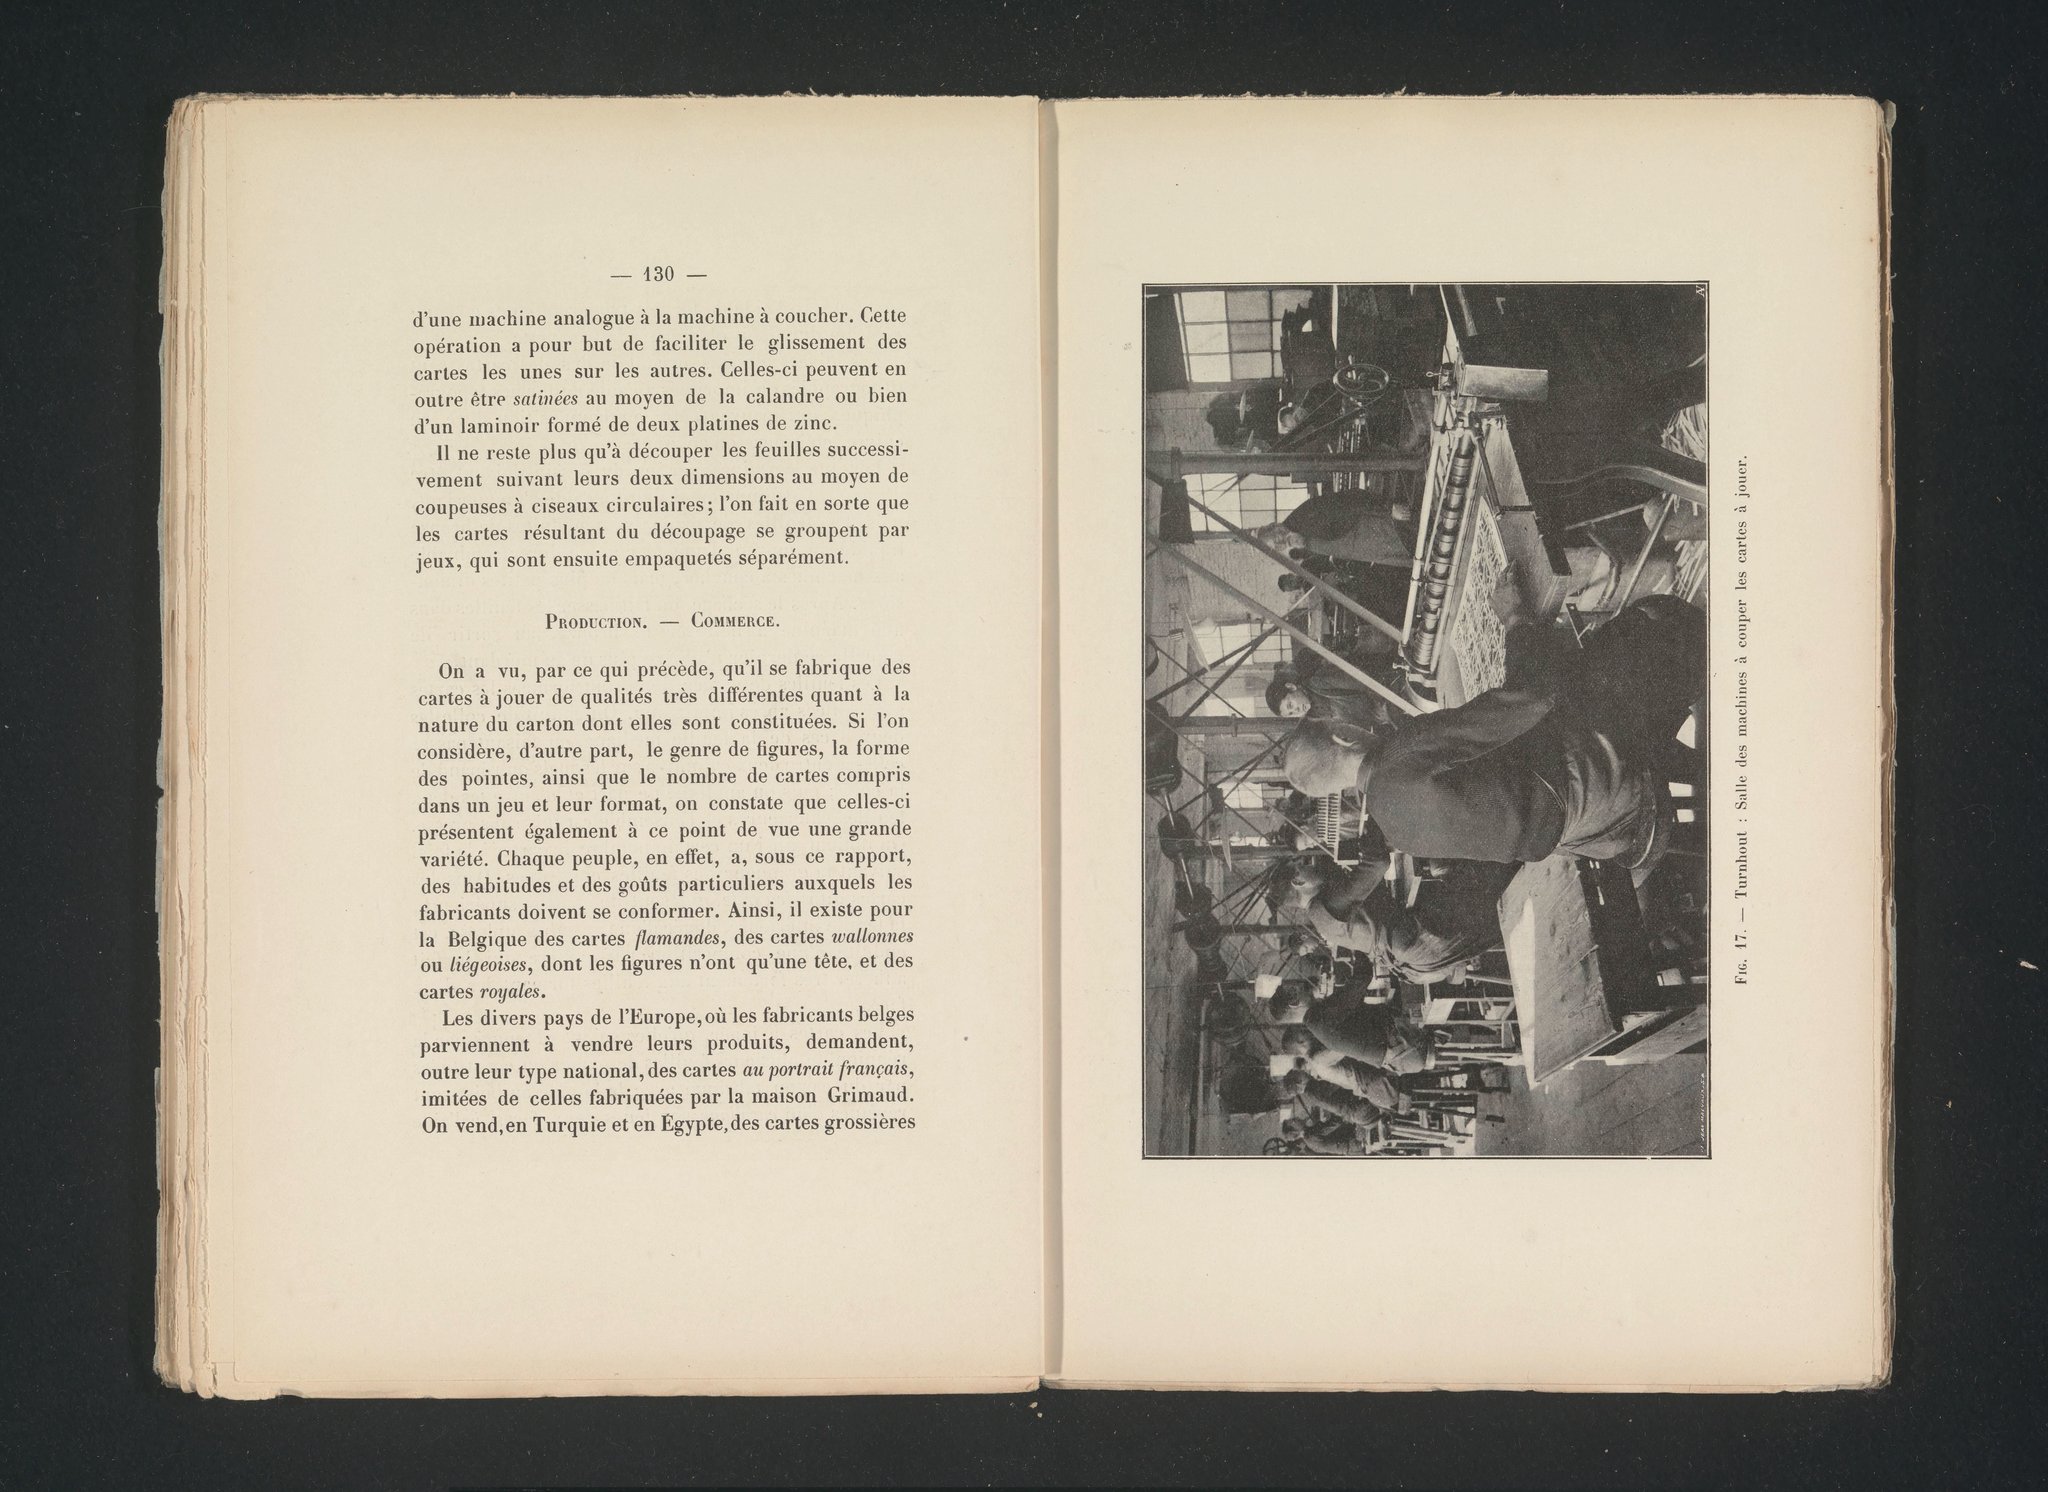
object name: page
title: Mannen snijden gedrukte speelkaarten uit in een drukkerij in Turnhout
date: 1901-1906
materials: paper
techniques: autotype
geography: turnhout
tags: adult man, printing, printing office, playing-cards, workshop-interior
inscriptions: inscription: ‘Fig. 17. - Turnhout: Salle des machines à couper les cartes à jouer.’, monogram: ‘AN’